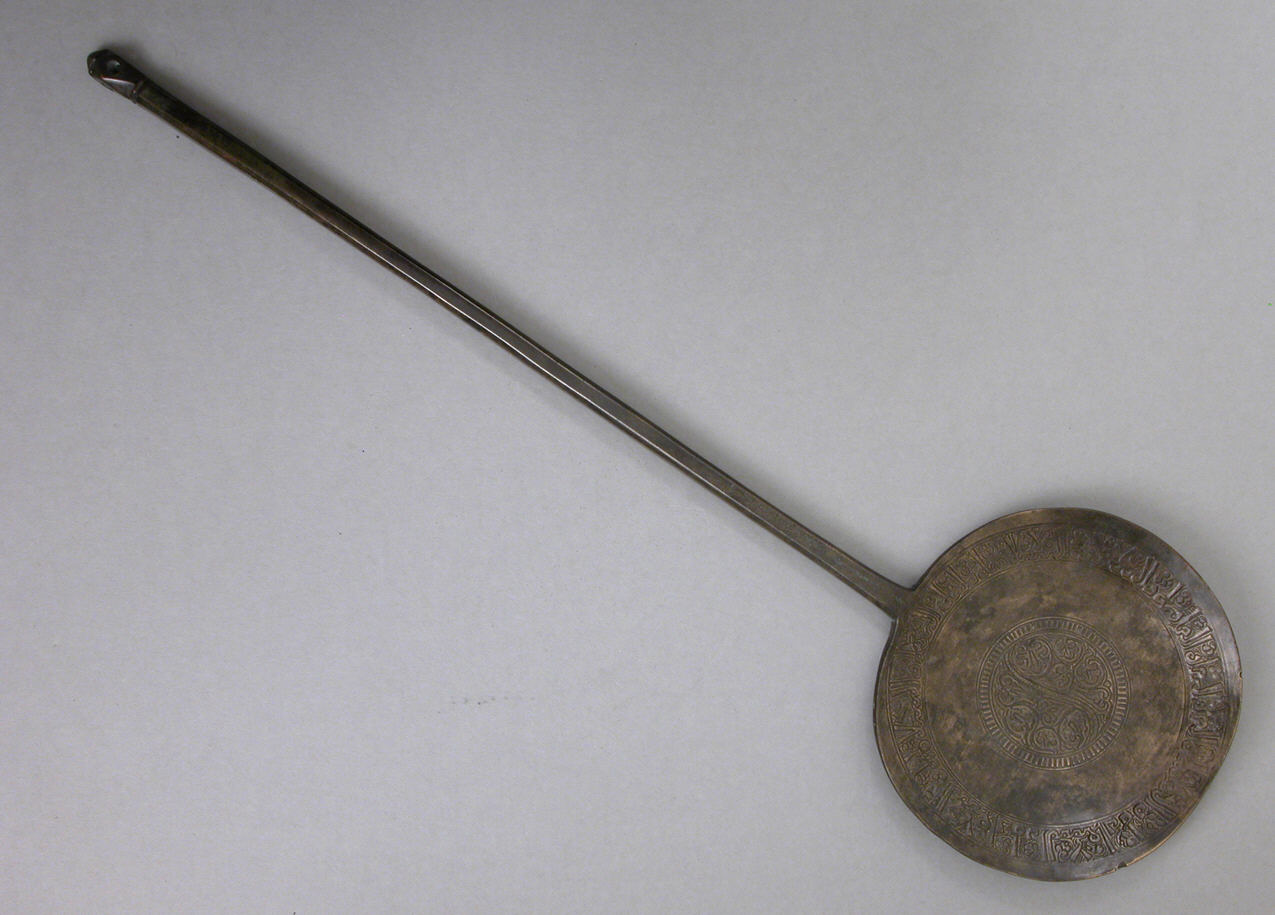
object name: mixing spoon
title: Long-Handled Spoon Inscribed in Arabic with Good Wishes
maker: mahmud ibn muhammad ibn abi al-hasan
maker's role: maker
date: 1001-1100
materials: alloy, bronze, tin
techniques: casting, chasing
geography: iran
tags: arabic